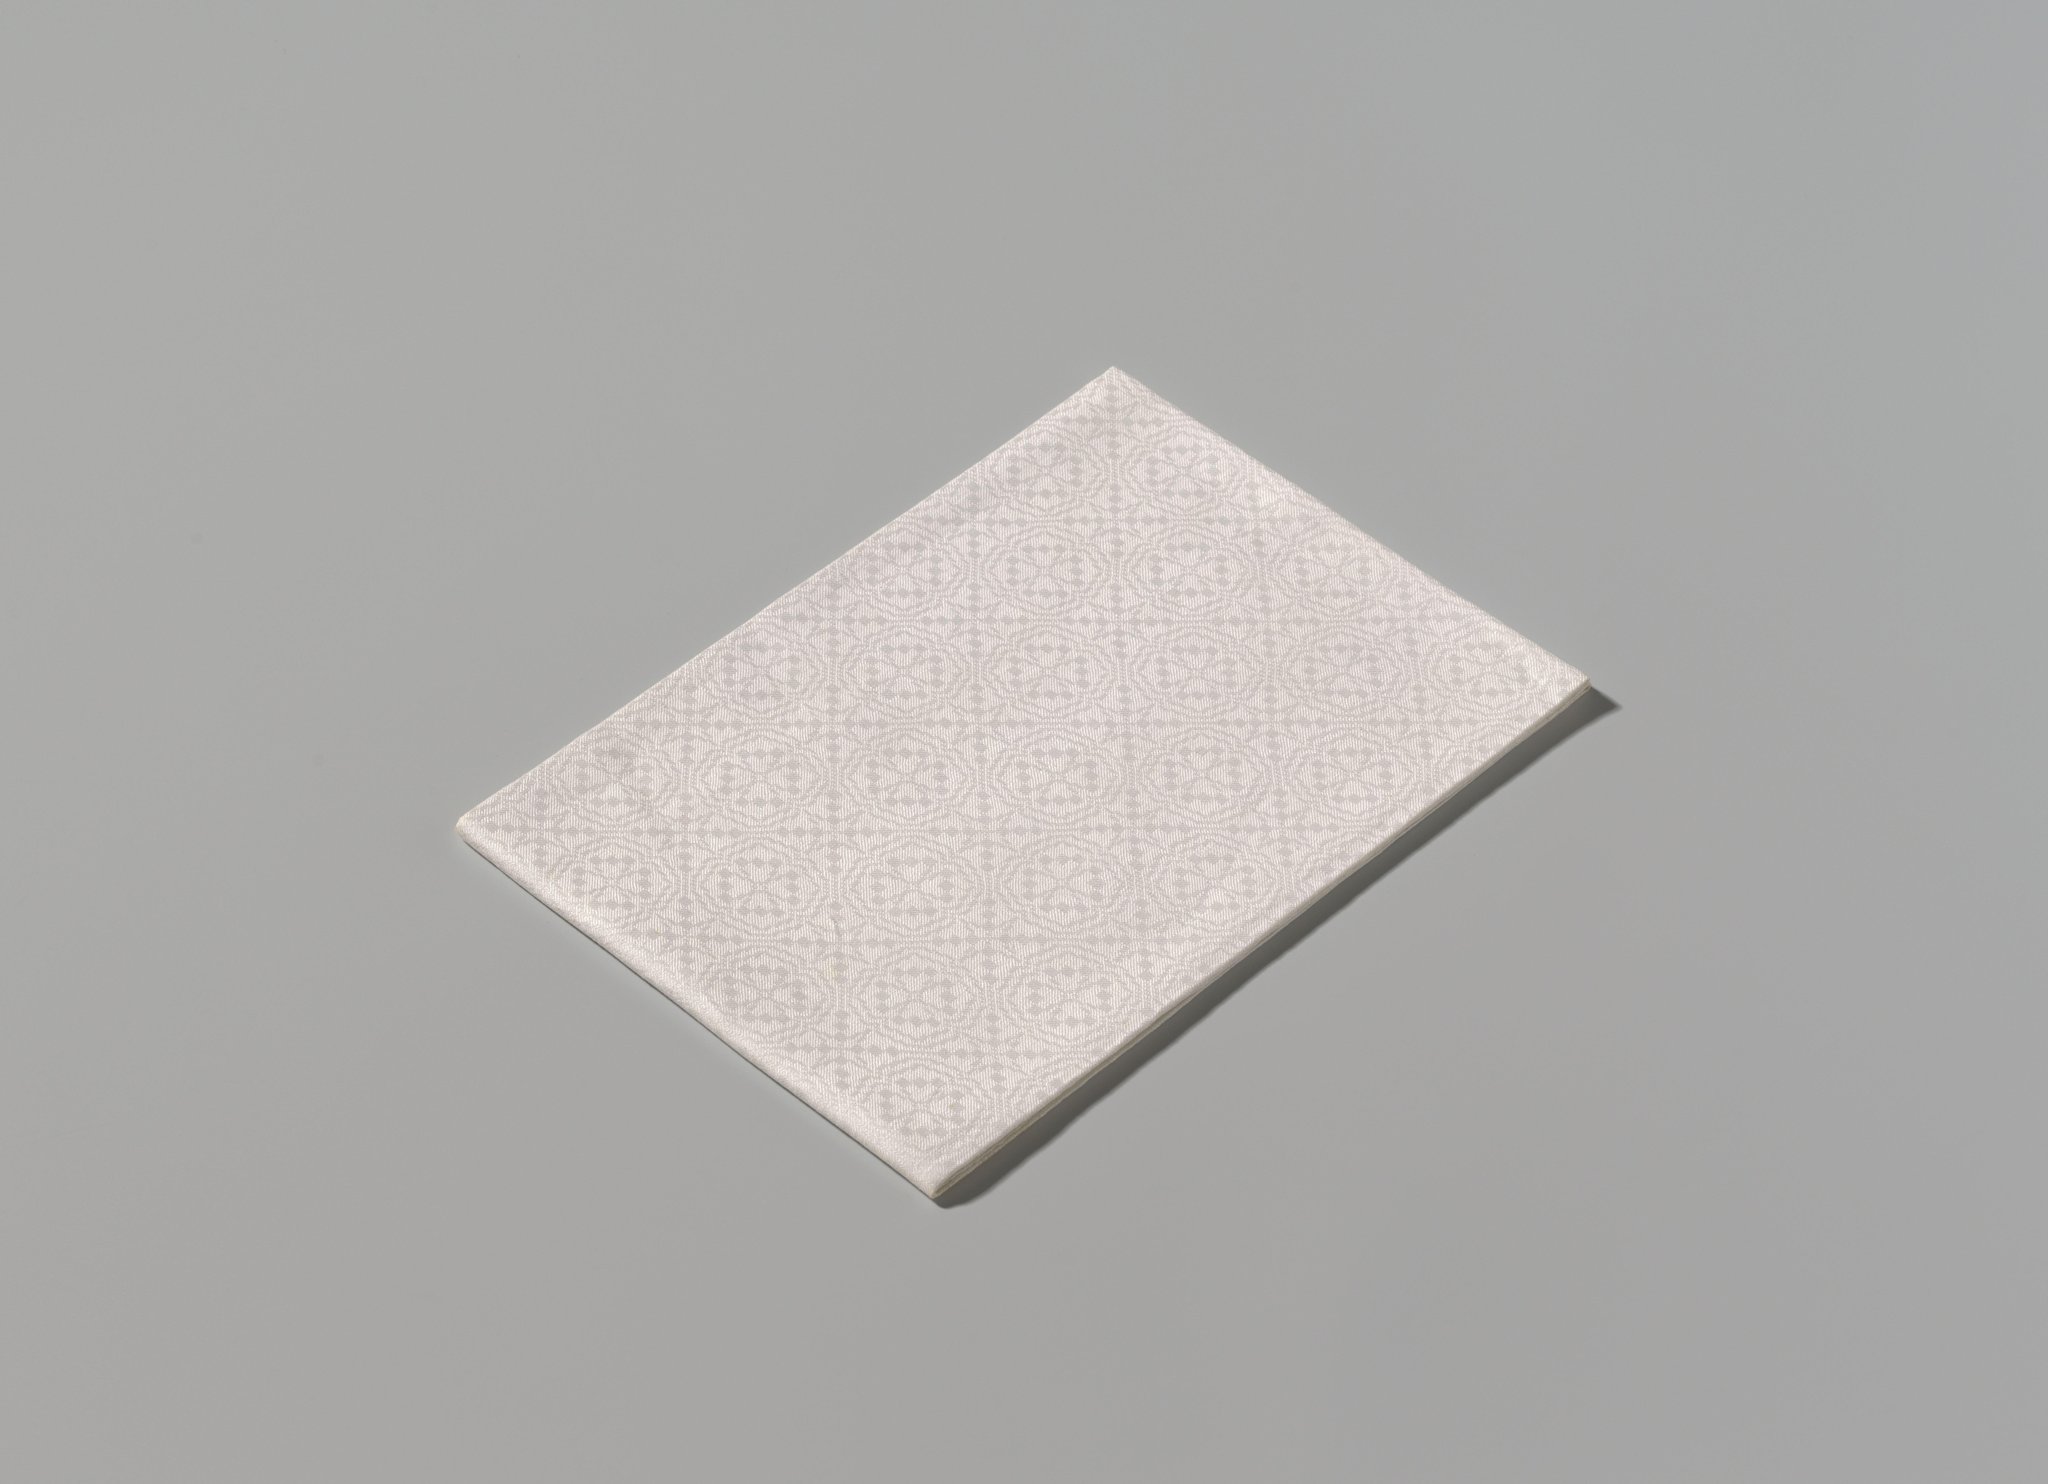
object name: napkin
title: Servet van wit linnen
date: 1640-1670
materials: linen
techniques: peeled fabric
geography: northern netherlands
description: Wit linnen servet. Pellen keper. Merk TC en 22.